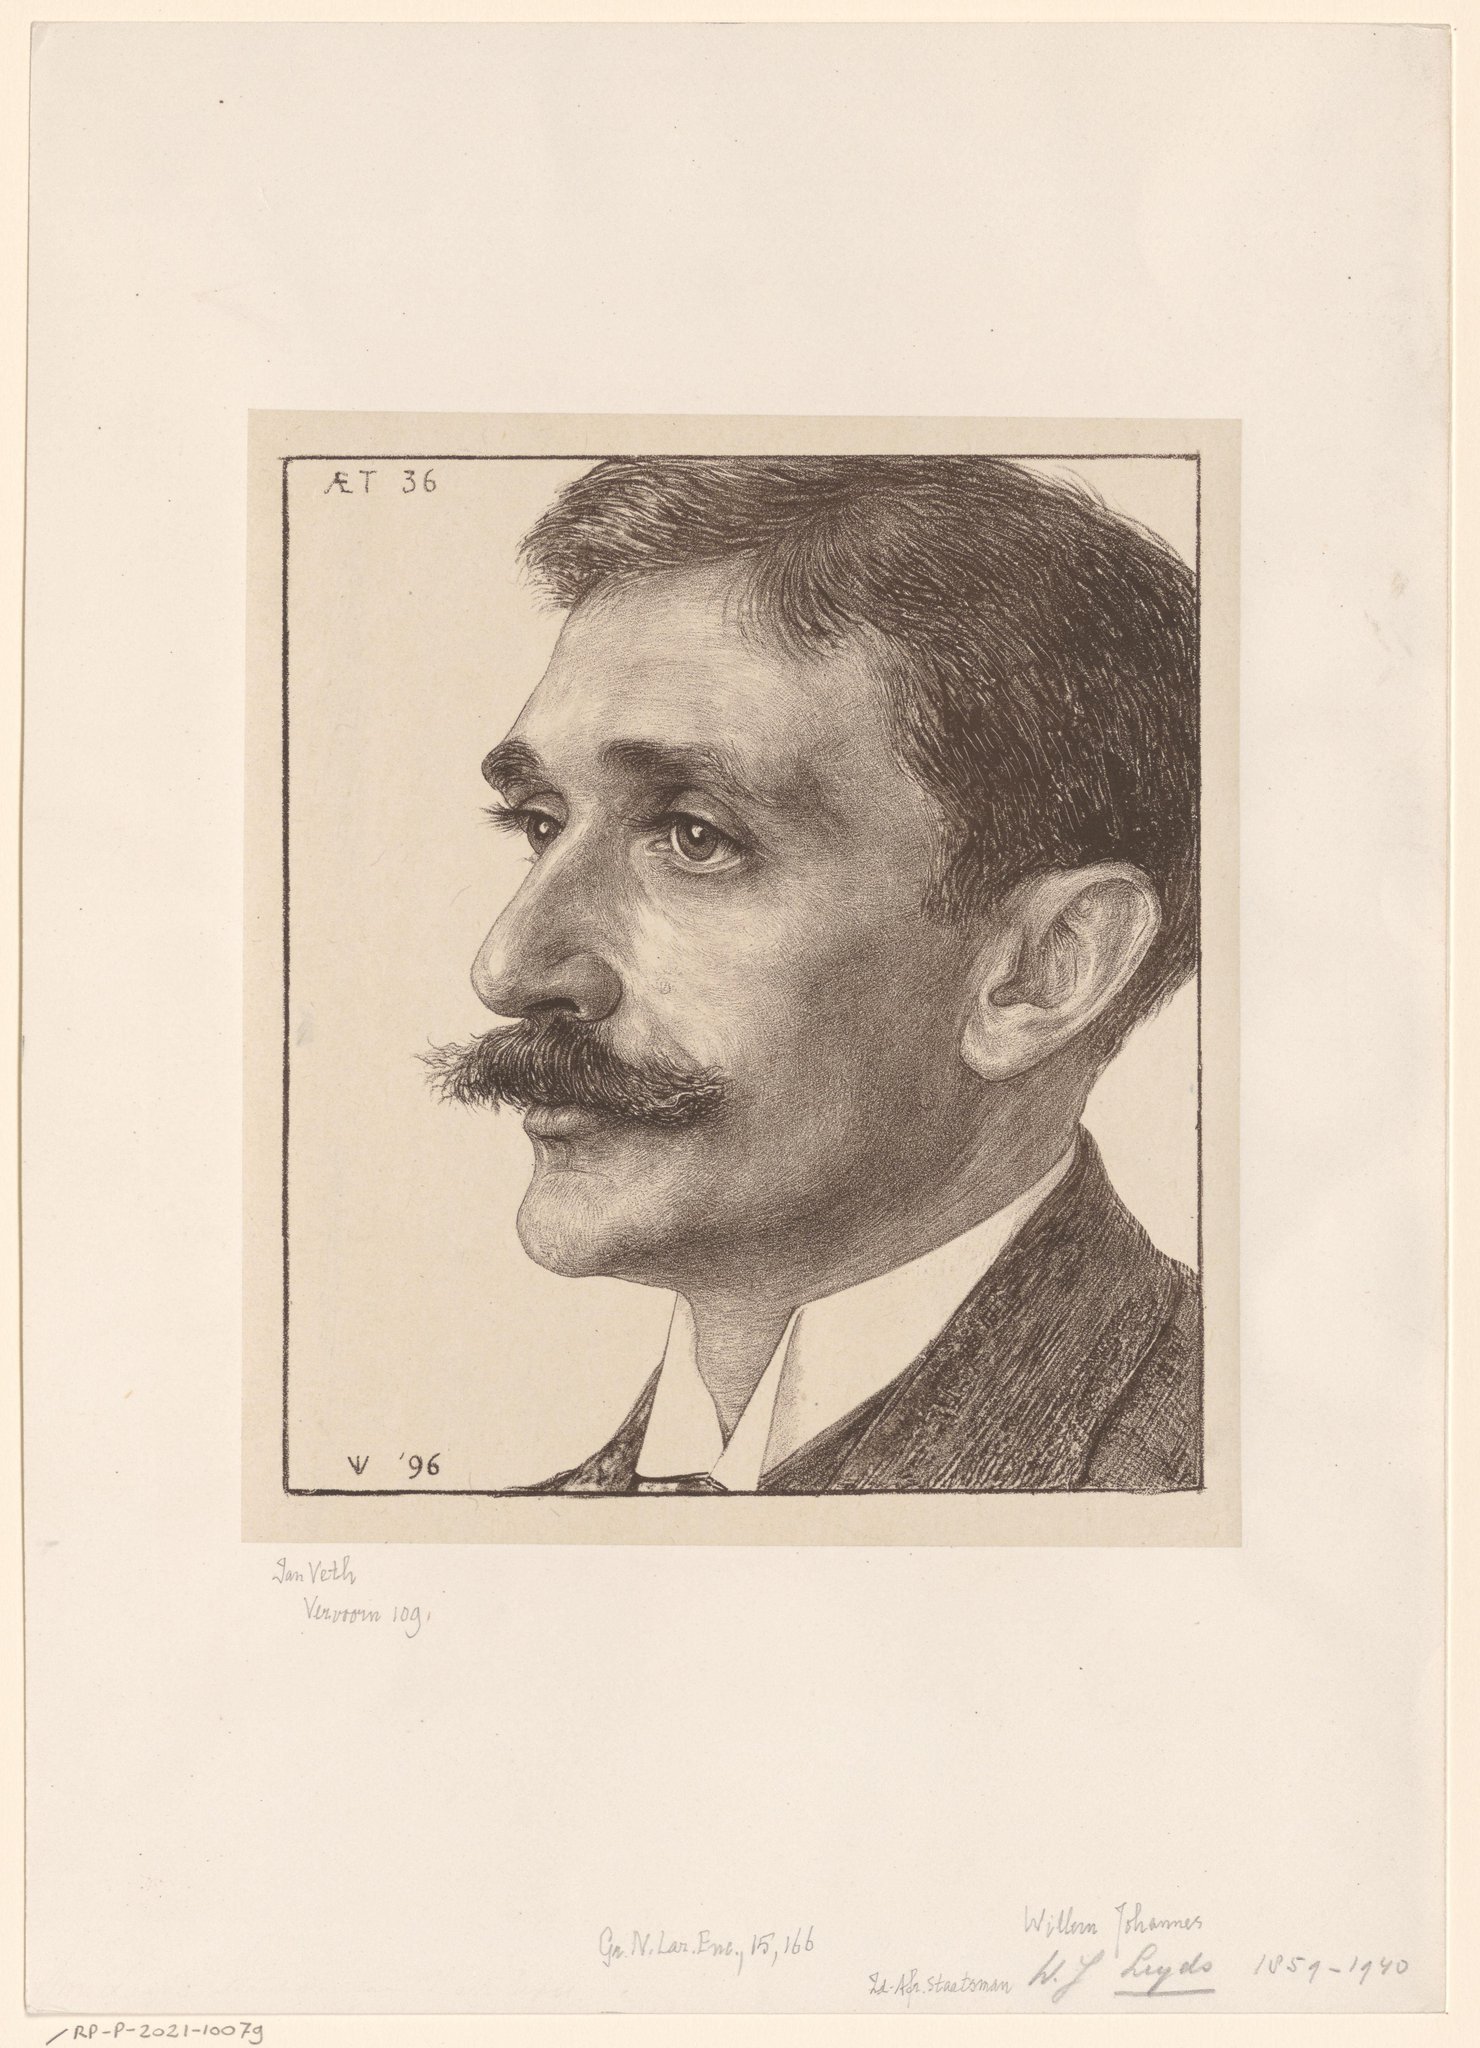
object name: print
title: Portret van Willem Johannes Leyds op 36-jarige leeftijd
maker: jan veth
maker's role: designer, draughtsman, painter, print maker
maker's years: 1864-1925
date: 1896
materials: paper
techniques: lithograph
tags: historical persons, diplomacy, diplomat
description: Latere staat van de prent gebruikt in de serie 'Portretten van De Kroniek'.